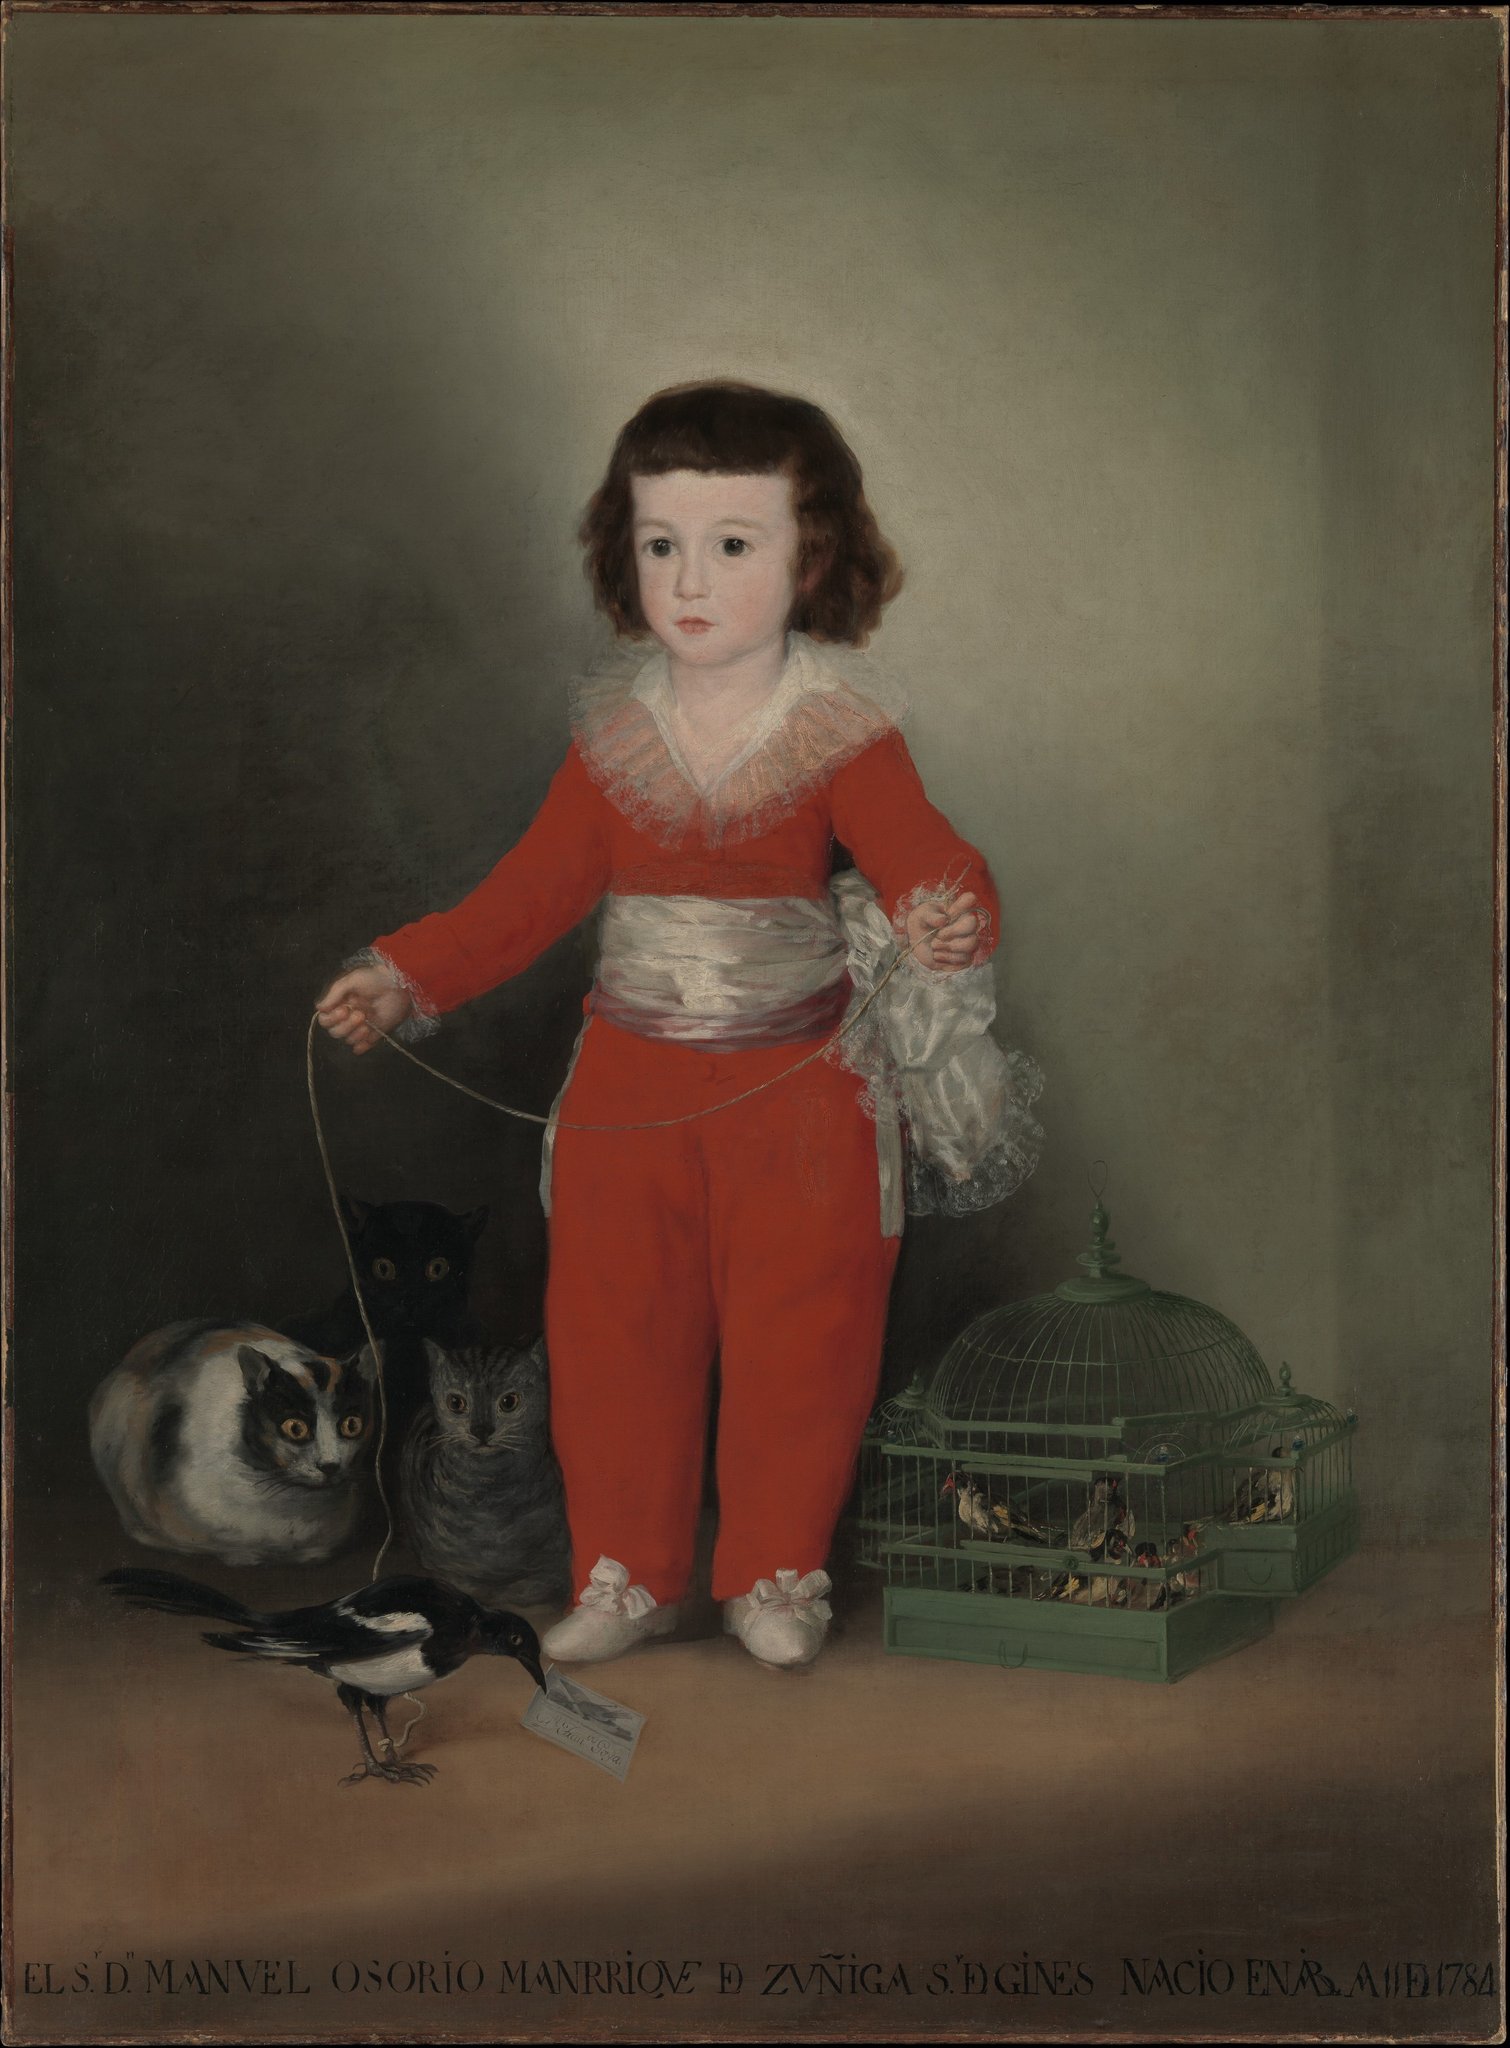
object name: painting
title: Manuel Osorio Manrique de Zuñiga (1784–1792)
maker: goya (francisco de goya y lucientes)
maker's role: artist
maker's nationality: spanish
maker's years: 1746-1828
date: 1787-1788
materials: canvas, oil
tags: birds,boys,portraits,cats